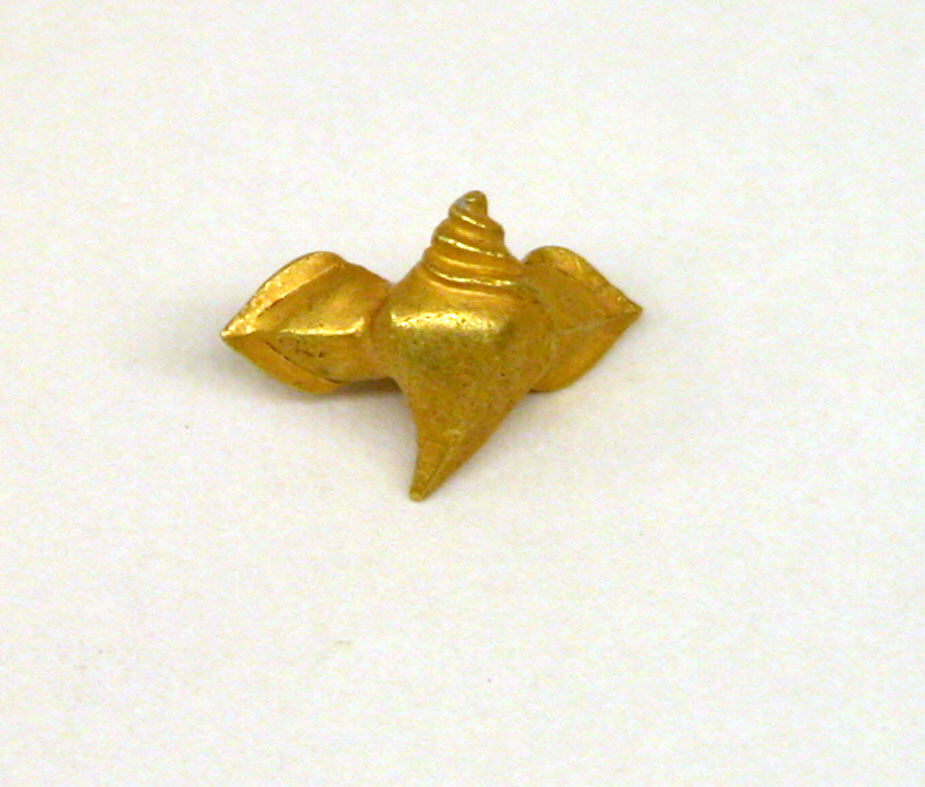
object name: ornament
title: Ornament with Shankha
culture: indonesian, javanese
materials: gold